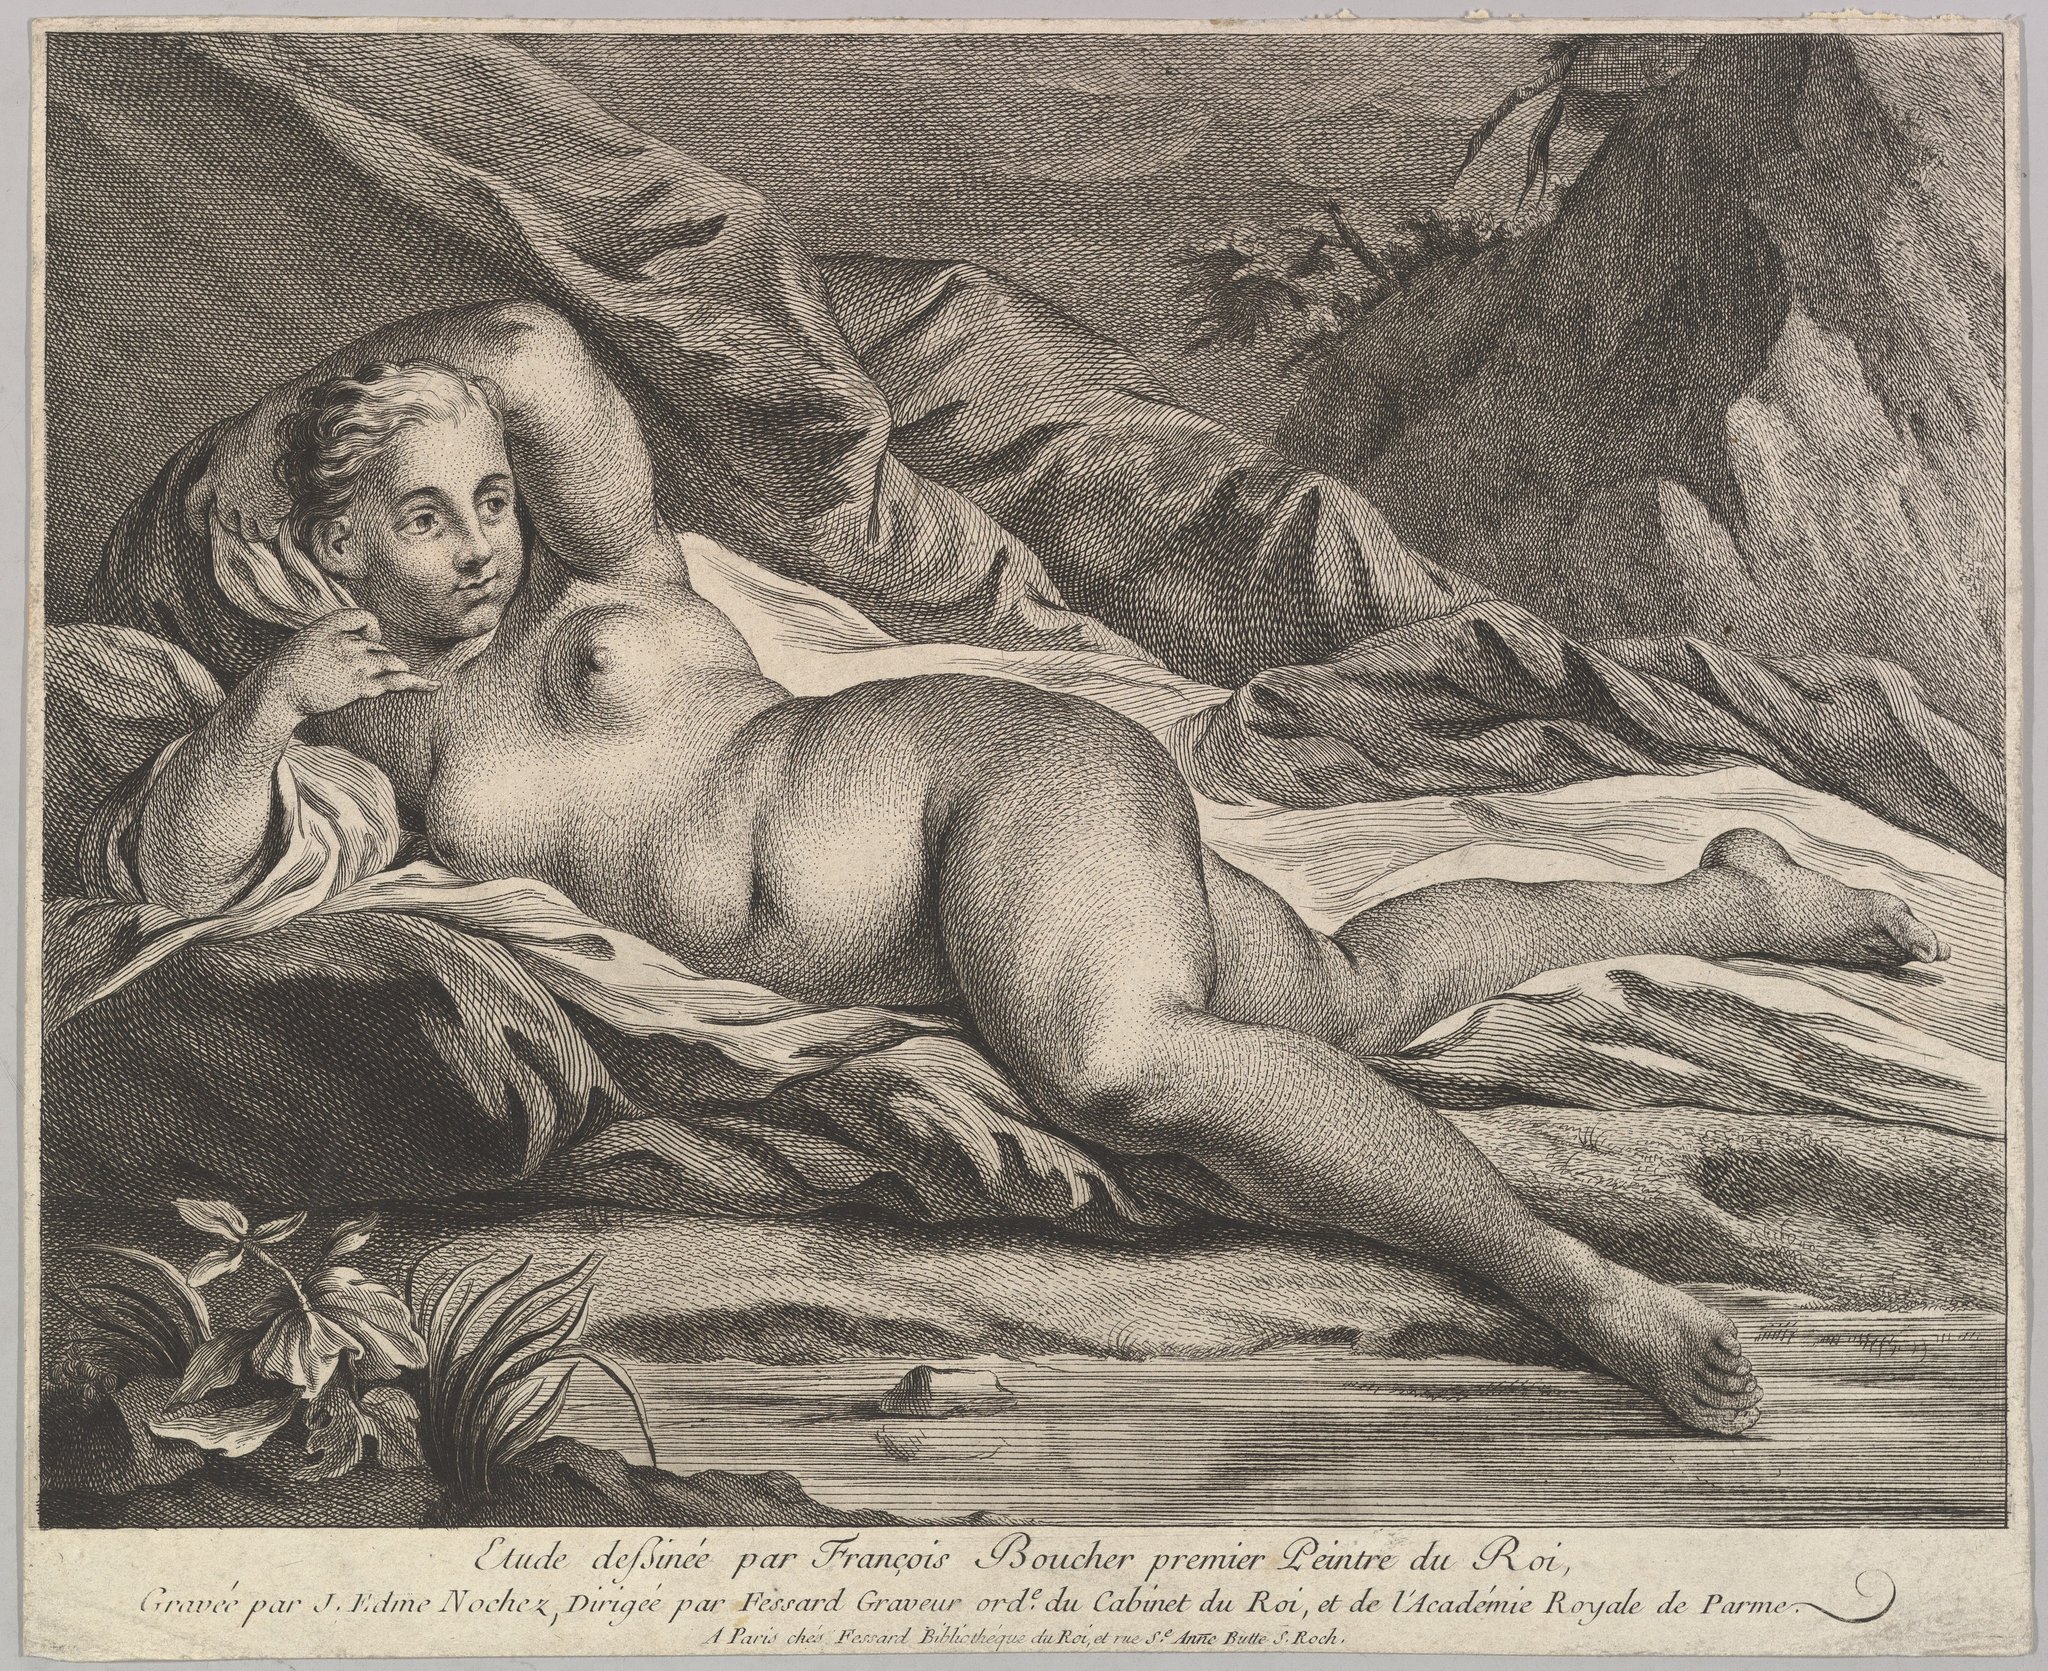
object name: print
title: Study of a Reclining Nude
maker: jean edme nochez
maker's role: artist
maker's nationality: french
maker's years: 1736-1800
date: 1736-1800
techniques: engraving, etching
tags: female nudes